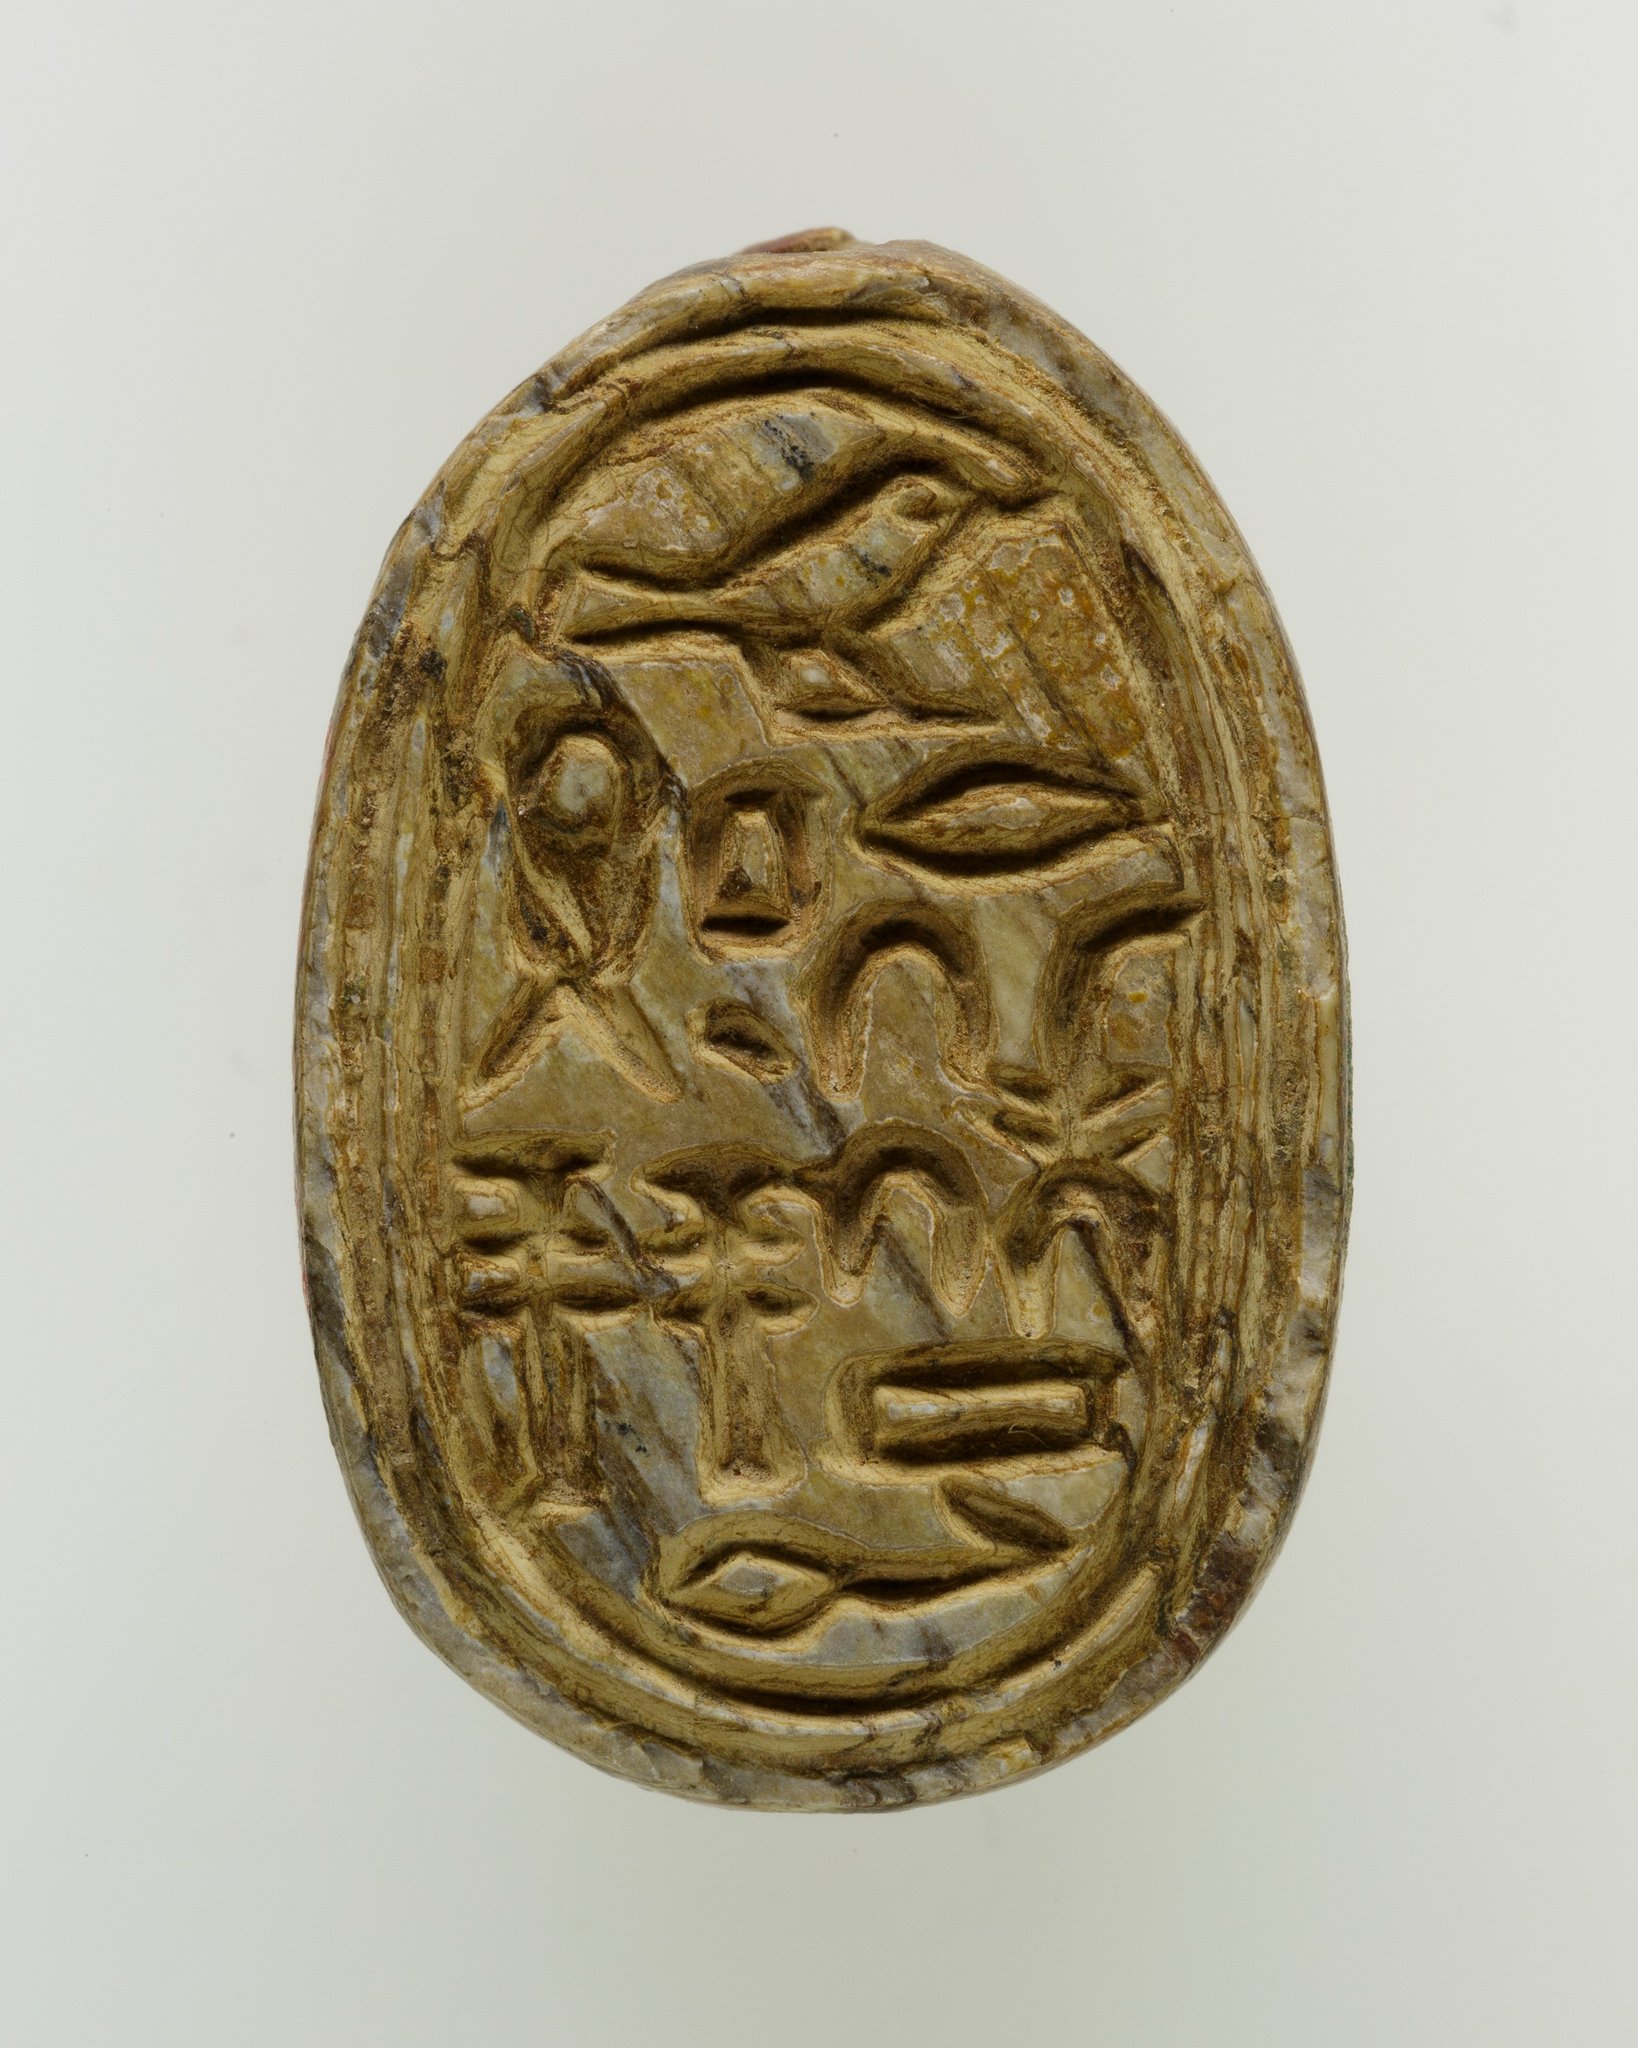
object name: scarab, official, private name and title, funerary epithet, djedptah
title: Scarab of an Official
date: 1760-1670 BCE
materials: stone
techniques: glazing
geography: egypt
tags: hieroglyphs,scarabs